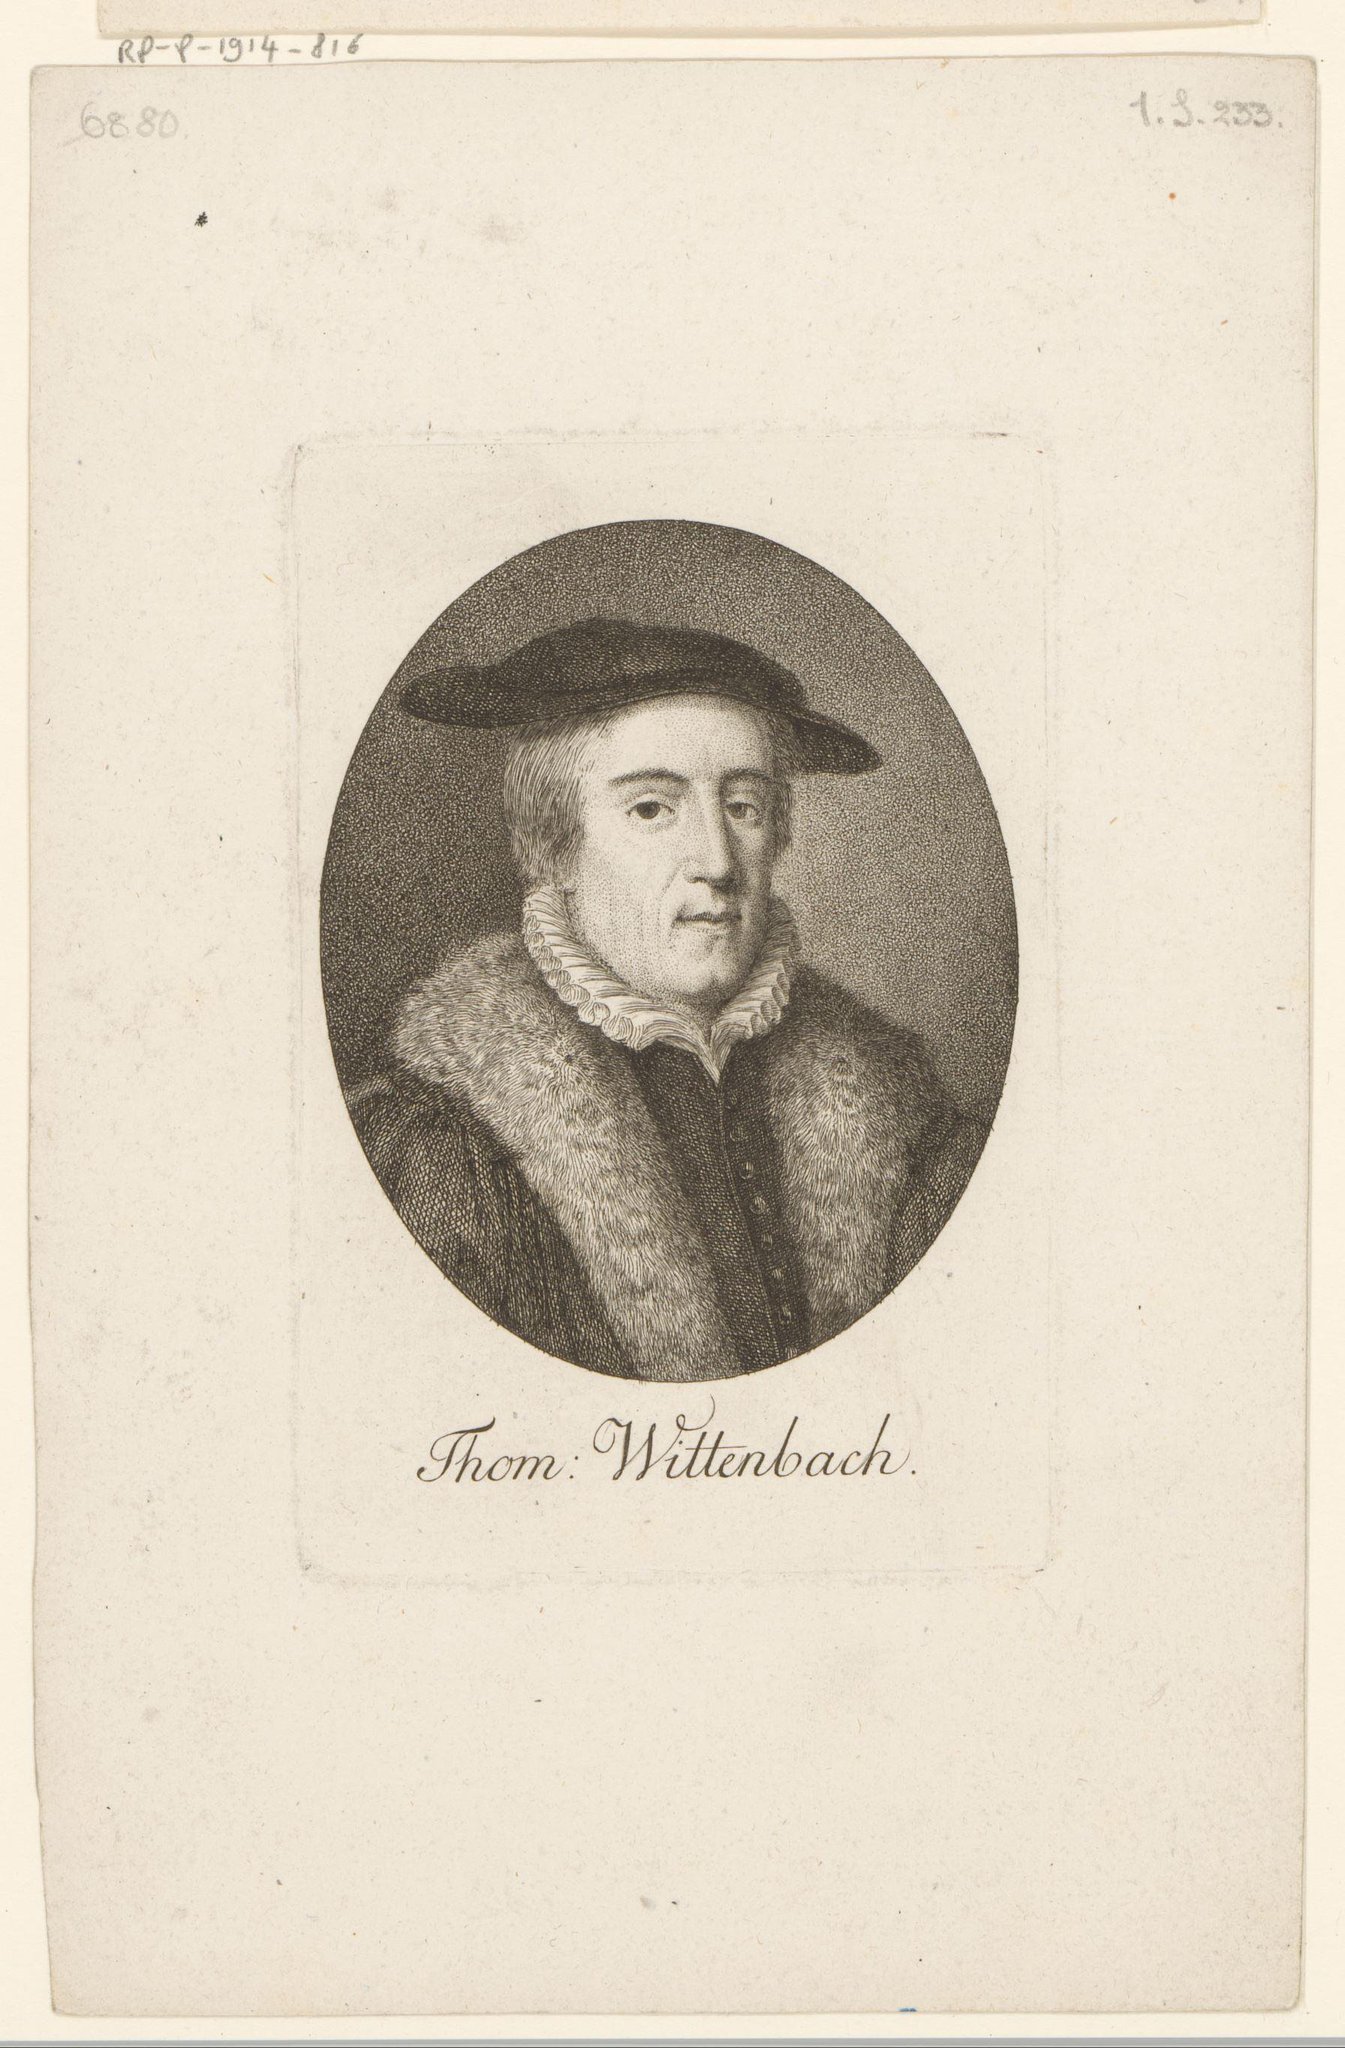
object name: print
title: Portret van Thomas Wyttenbach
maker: heinrich pfenninger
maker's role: print maker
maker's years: 1749-1815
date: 1759-1815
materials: paper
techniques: etching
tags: historical persons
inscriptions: collector's mark: Lugt 2228